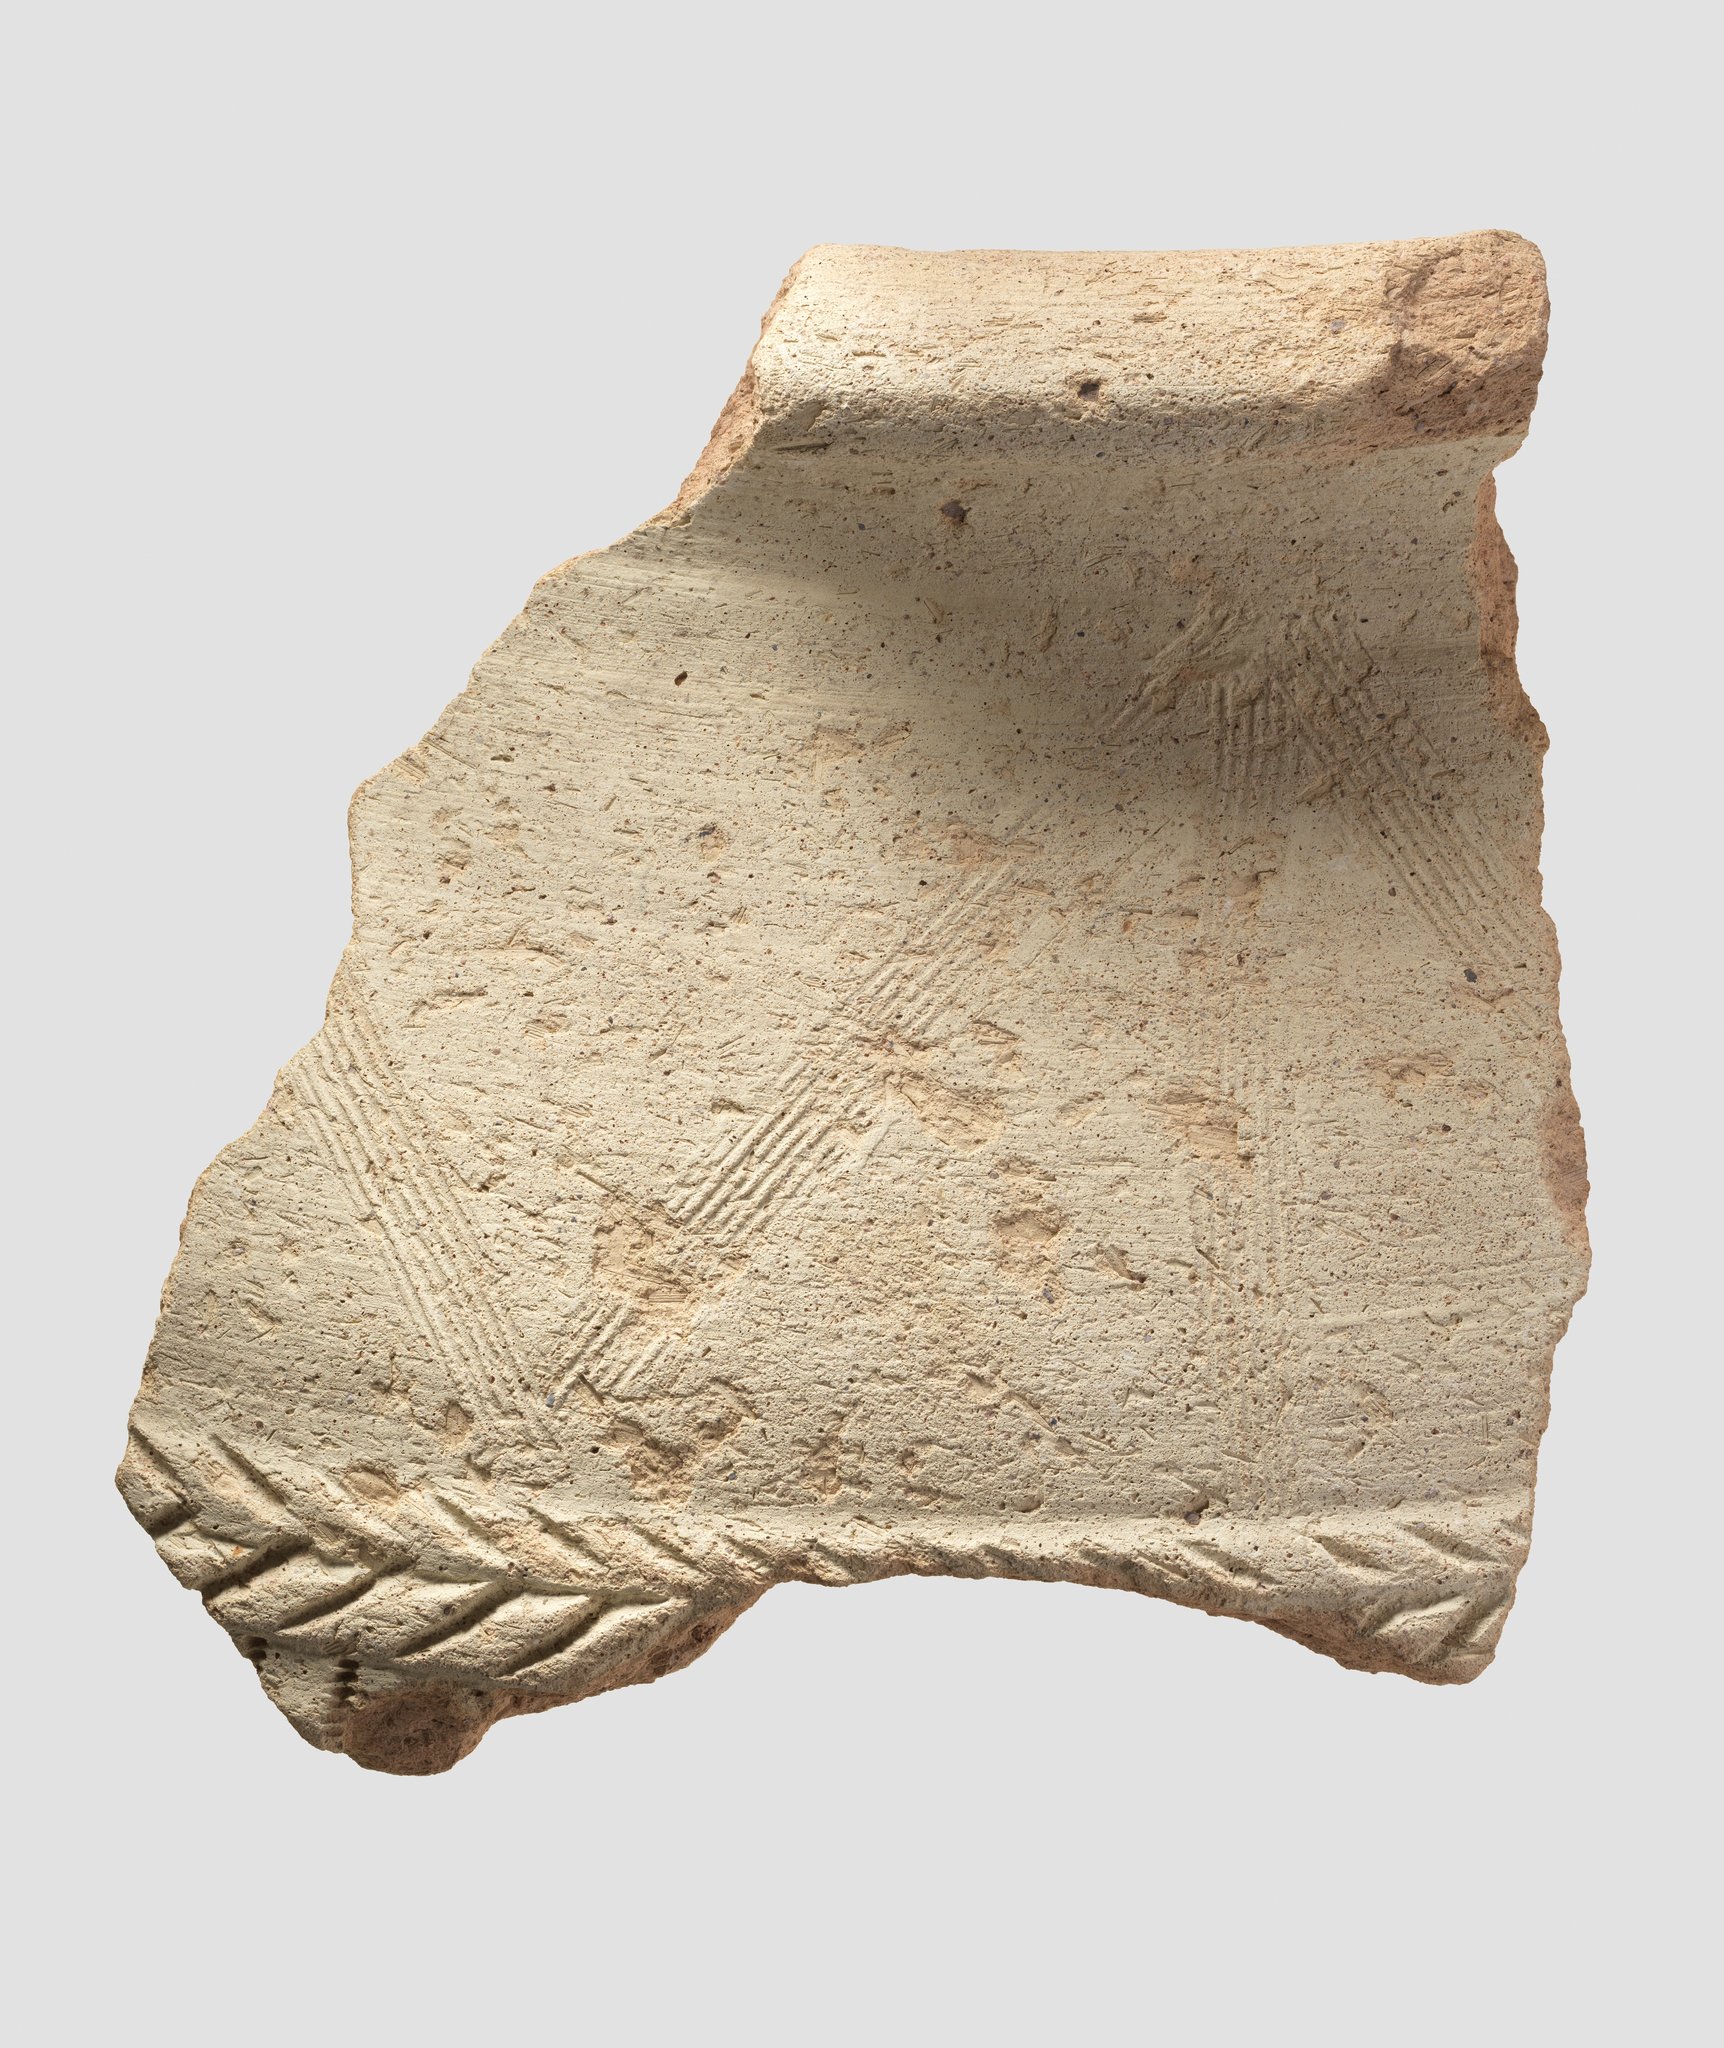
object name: jar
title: Jar rim sherd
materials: ceramic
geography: mesopotamia